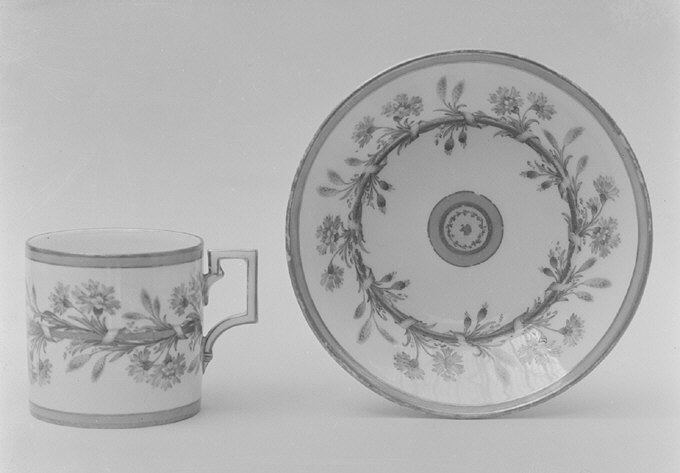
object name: cup and saucer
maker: royal porcelain manufactory, berlin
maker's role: manufactory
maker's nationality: german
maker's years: 1763-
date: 1790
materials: hard paste porcelain